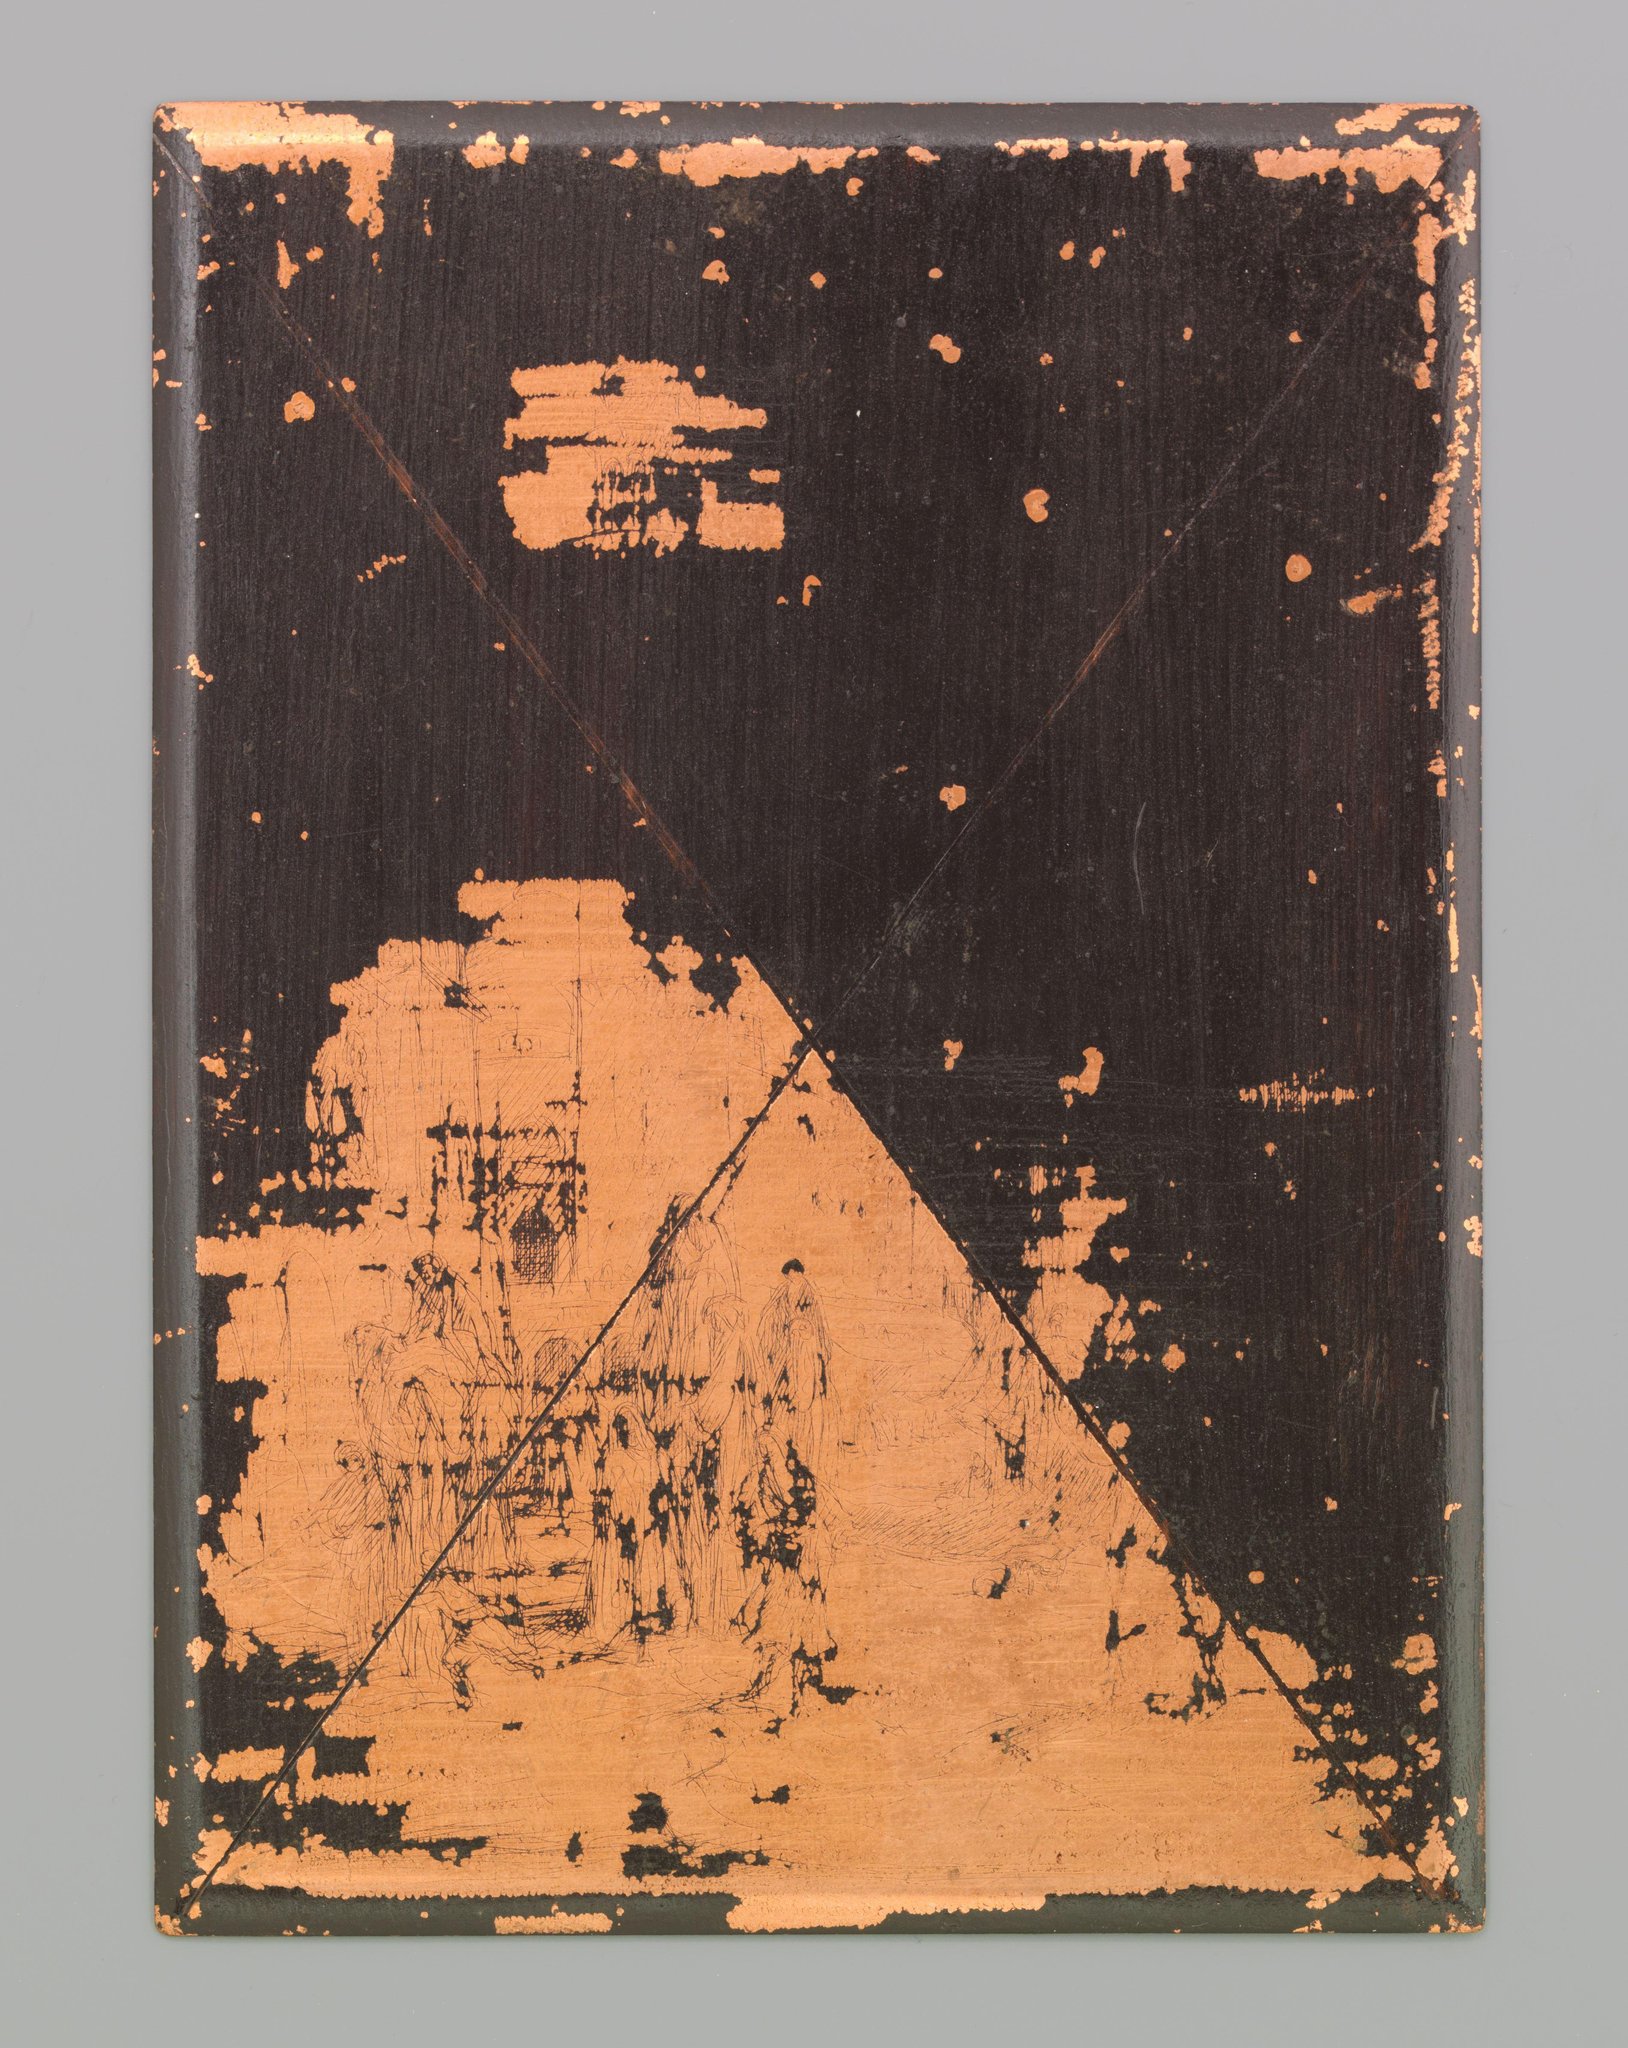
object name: copper plate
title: Moskee te Mutta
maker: marius bauer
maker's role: draughtsman, print maker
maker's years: 1867-1932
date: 1924-1932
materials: copper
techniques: etching